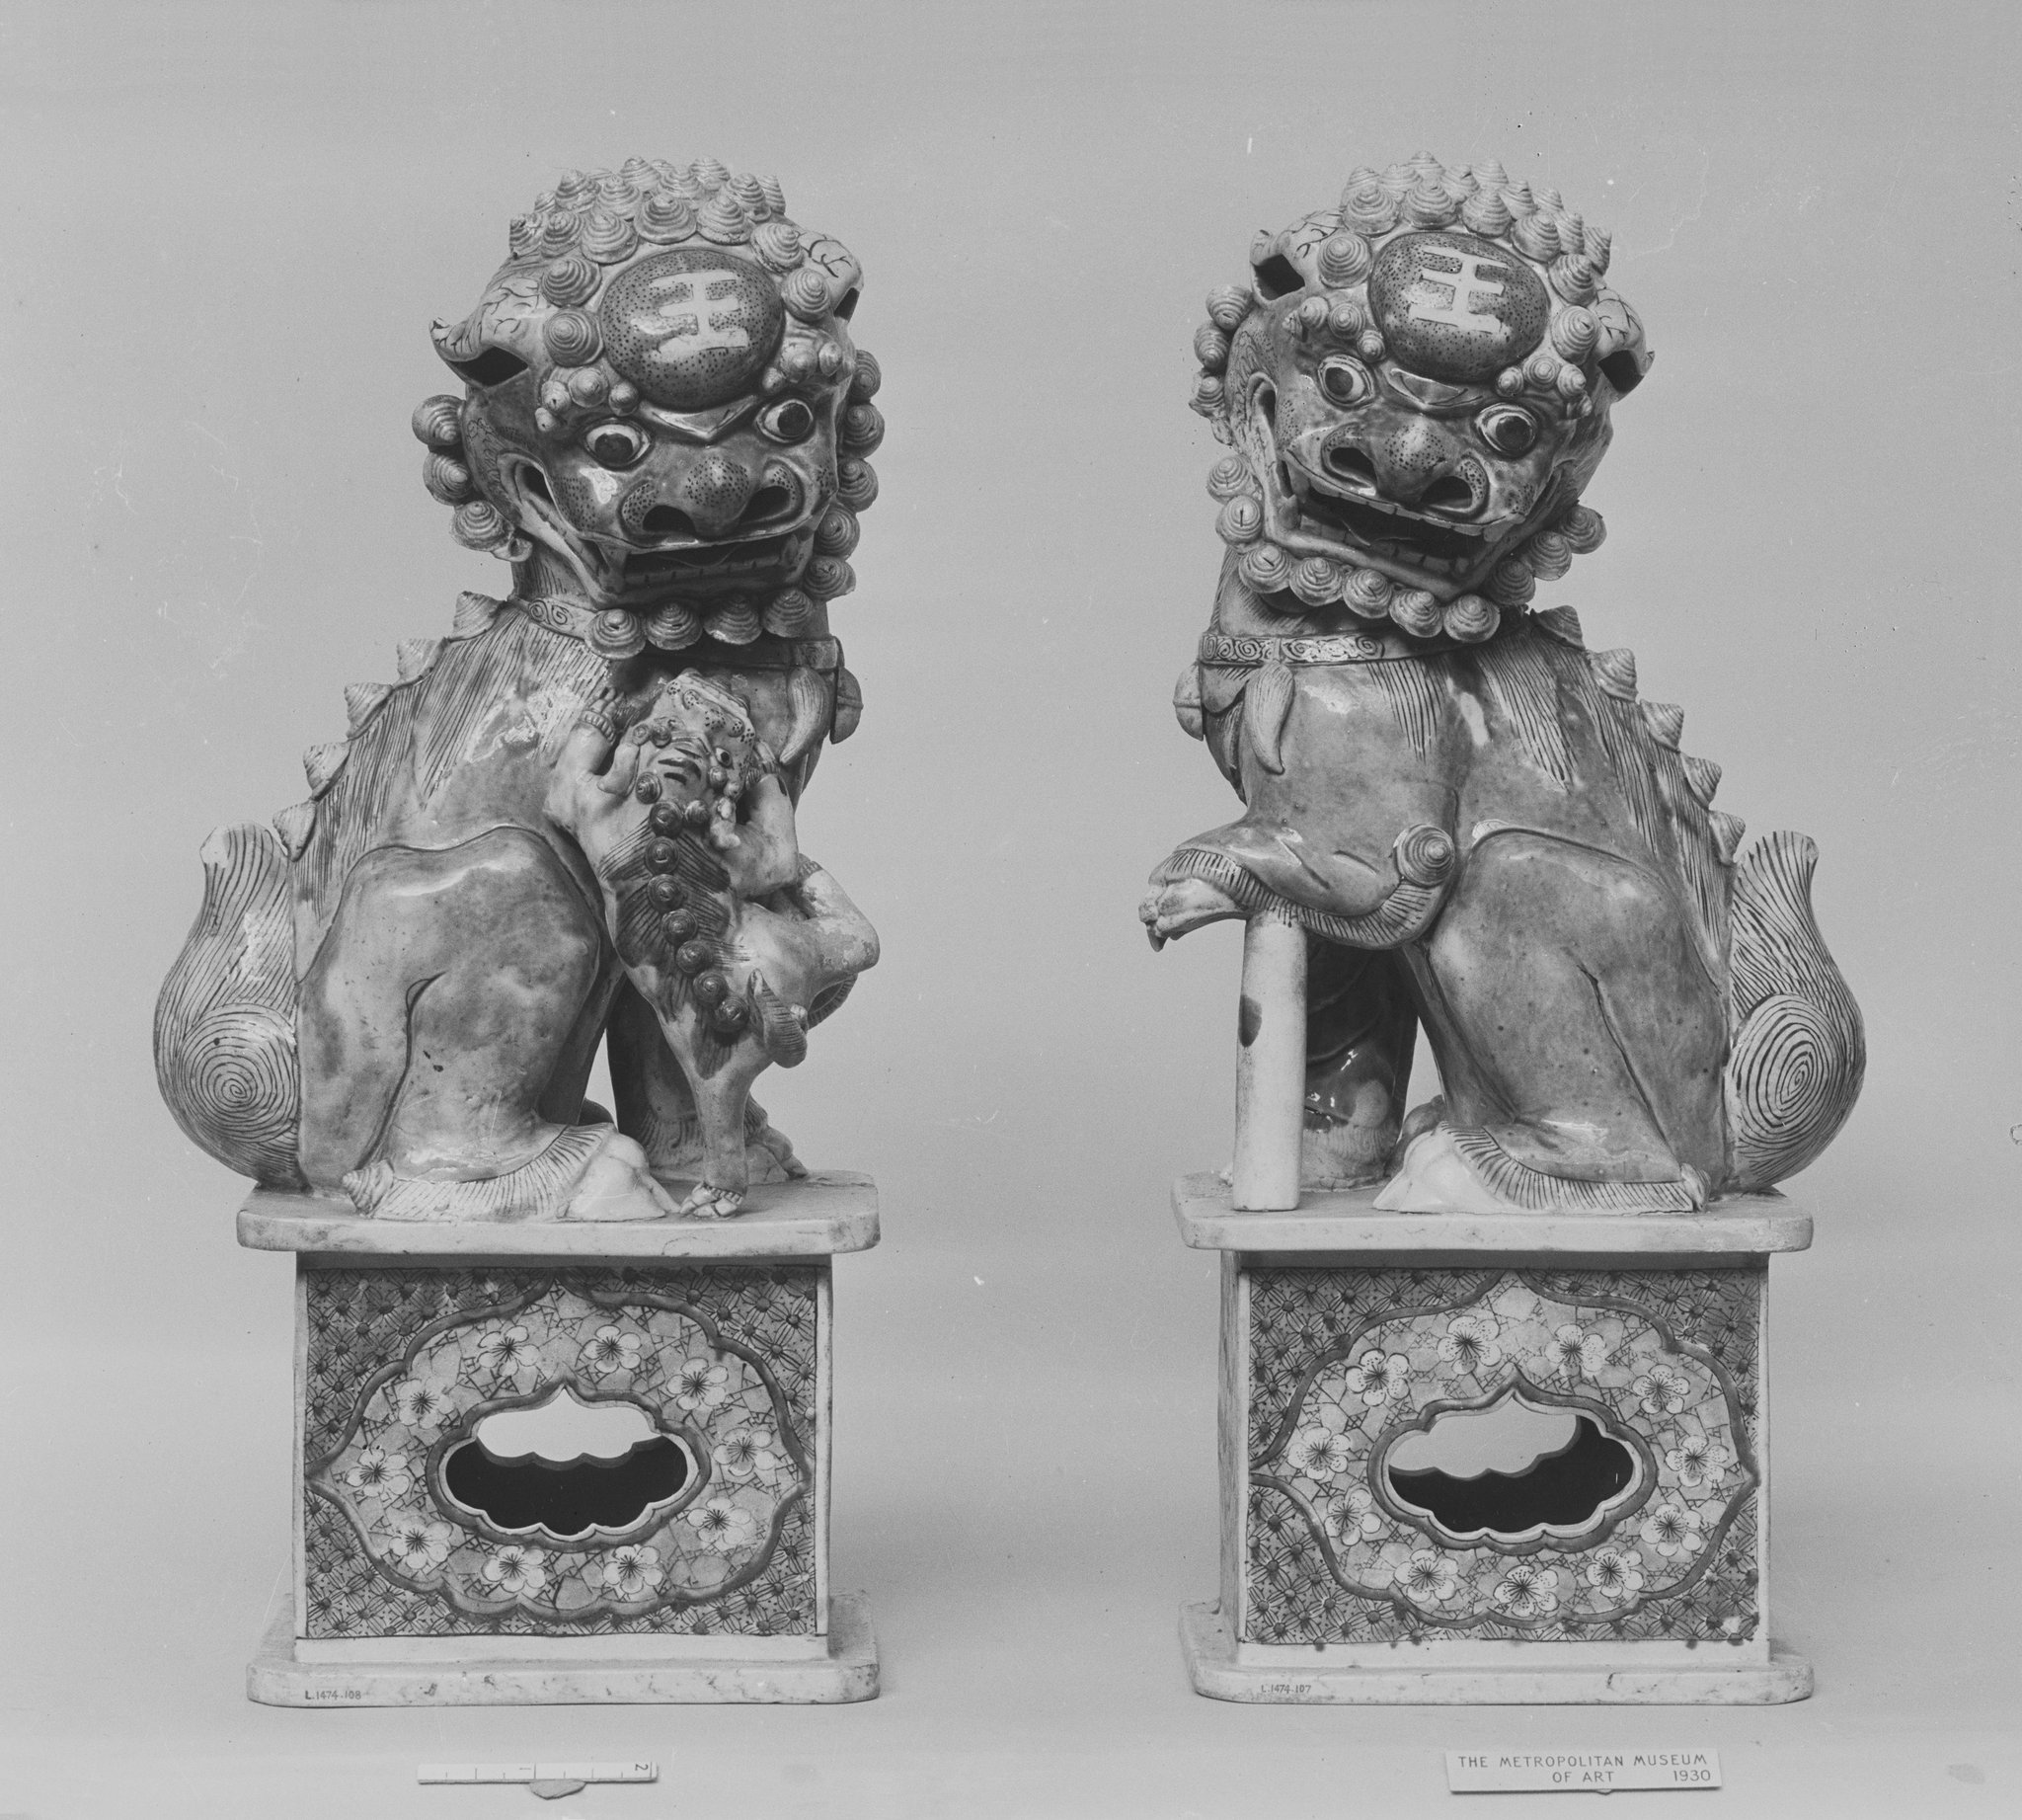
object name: figure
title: Figure of a Lion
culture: chinese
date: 1662-1722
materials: porcelain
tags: lions